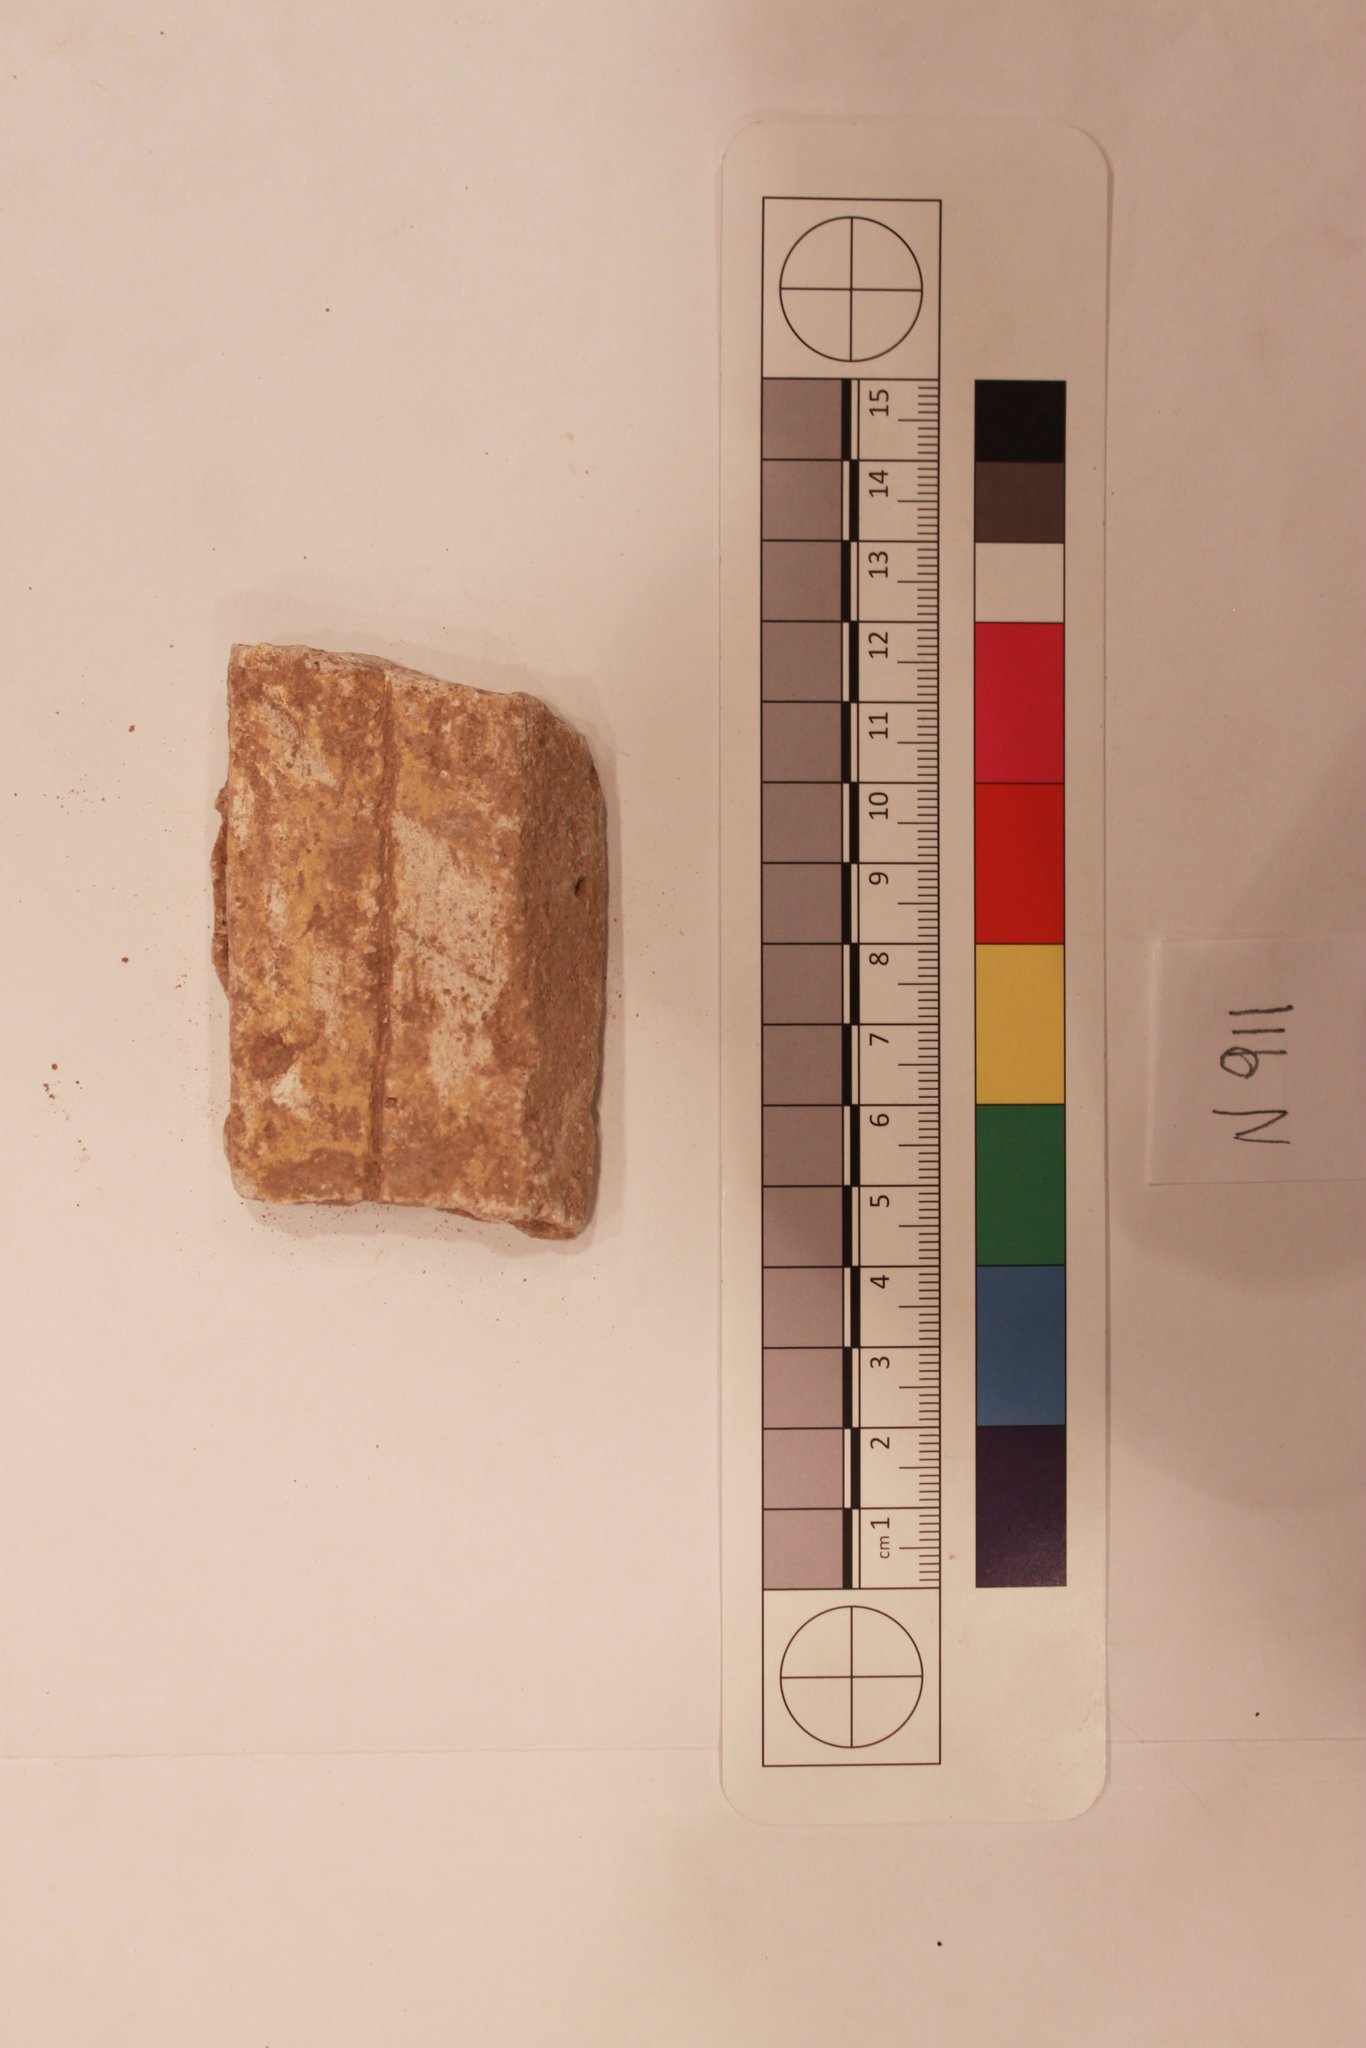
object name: fragment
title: Stucco Fragment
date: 701-1200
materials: plaster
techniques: carving, painting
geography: iran